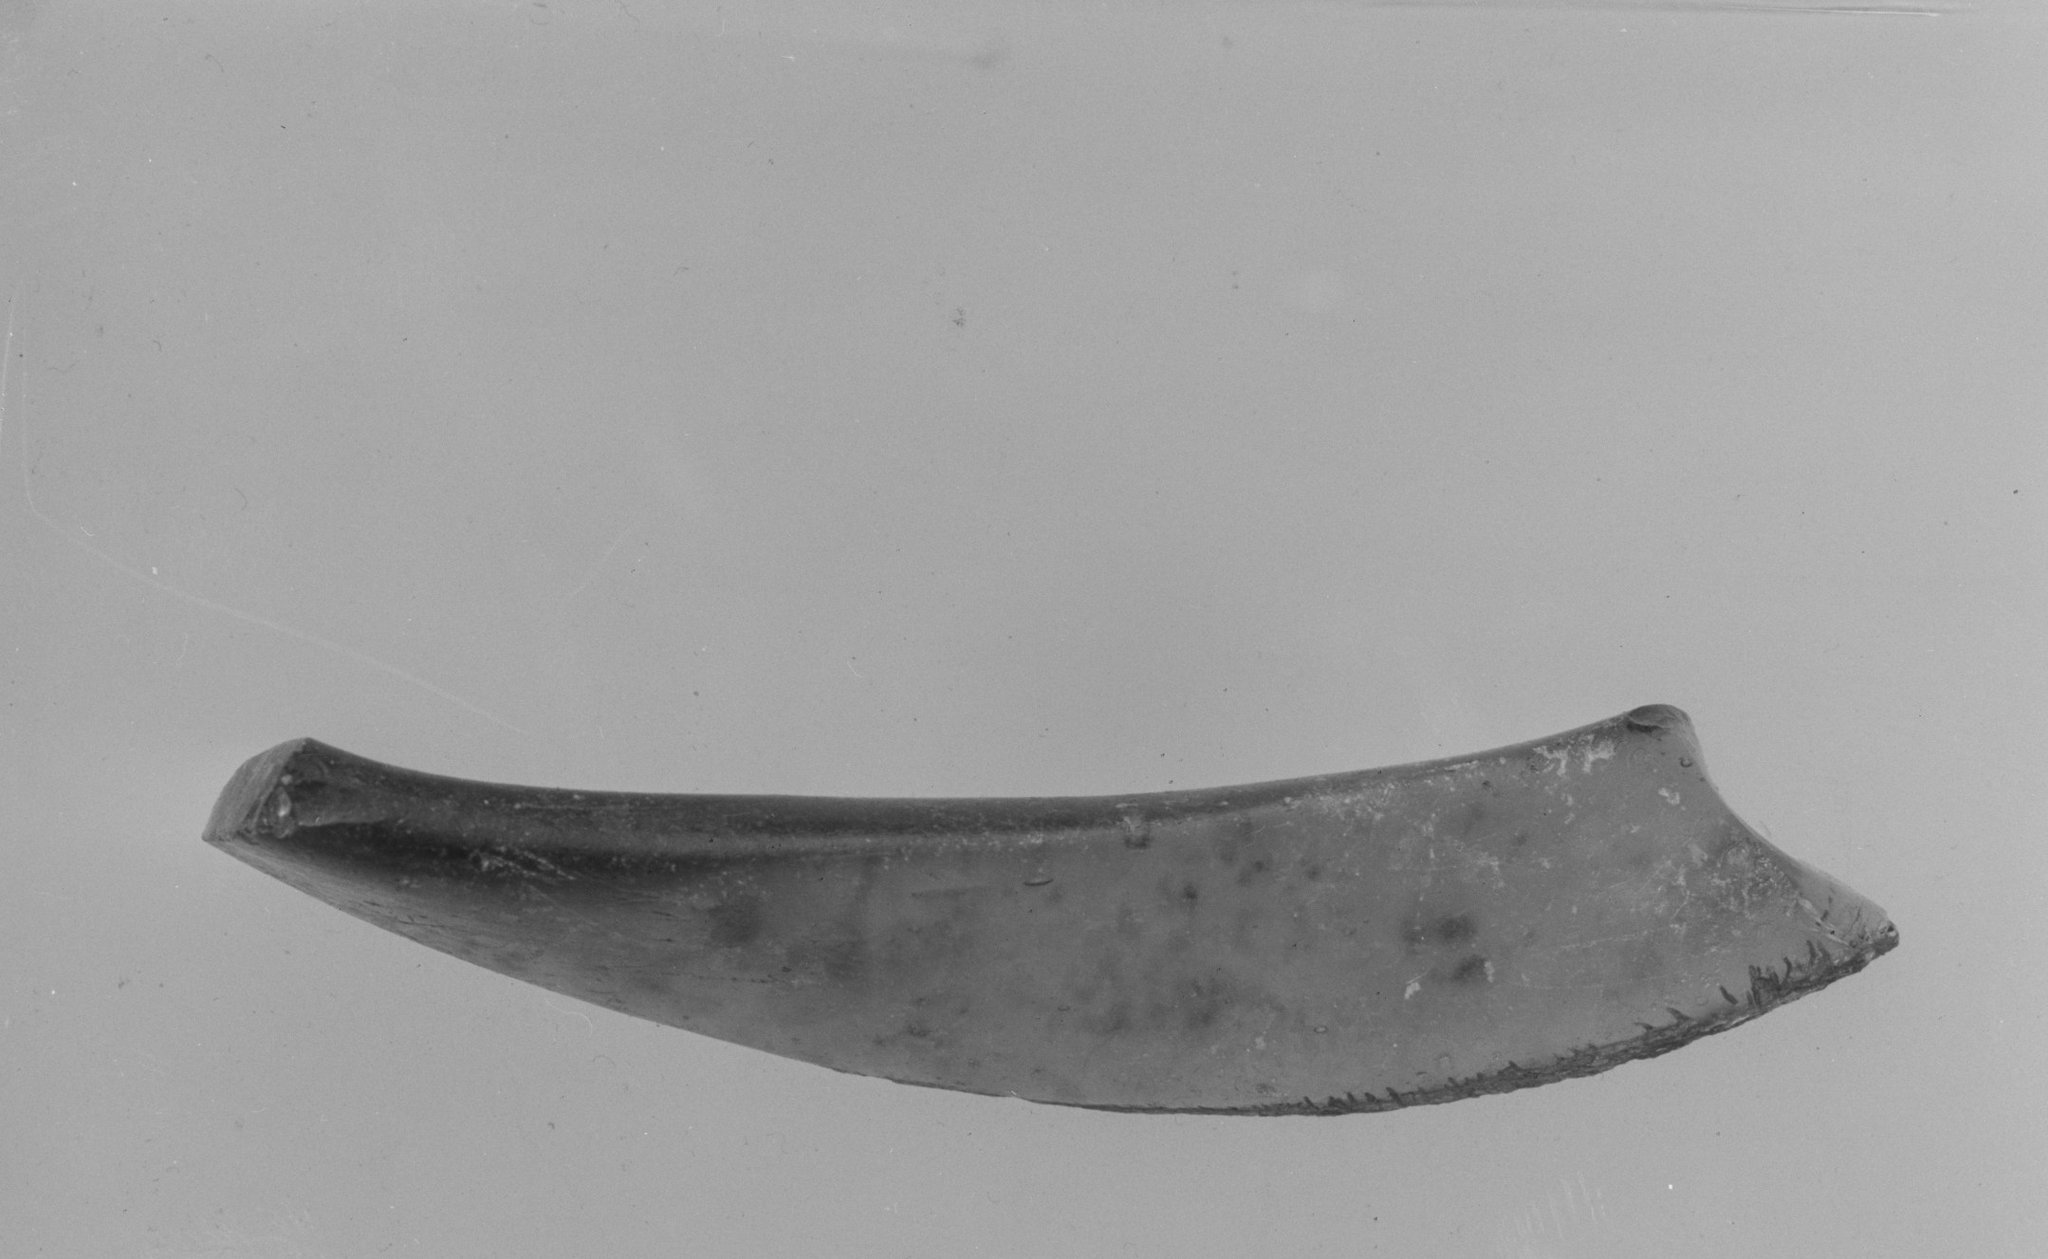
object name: fragment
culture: american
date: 1700-1800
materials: glass, lead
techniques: glassblowing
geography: united states